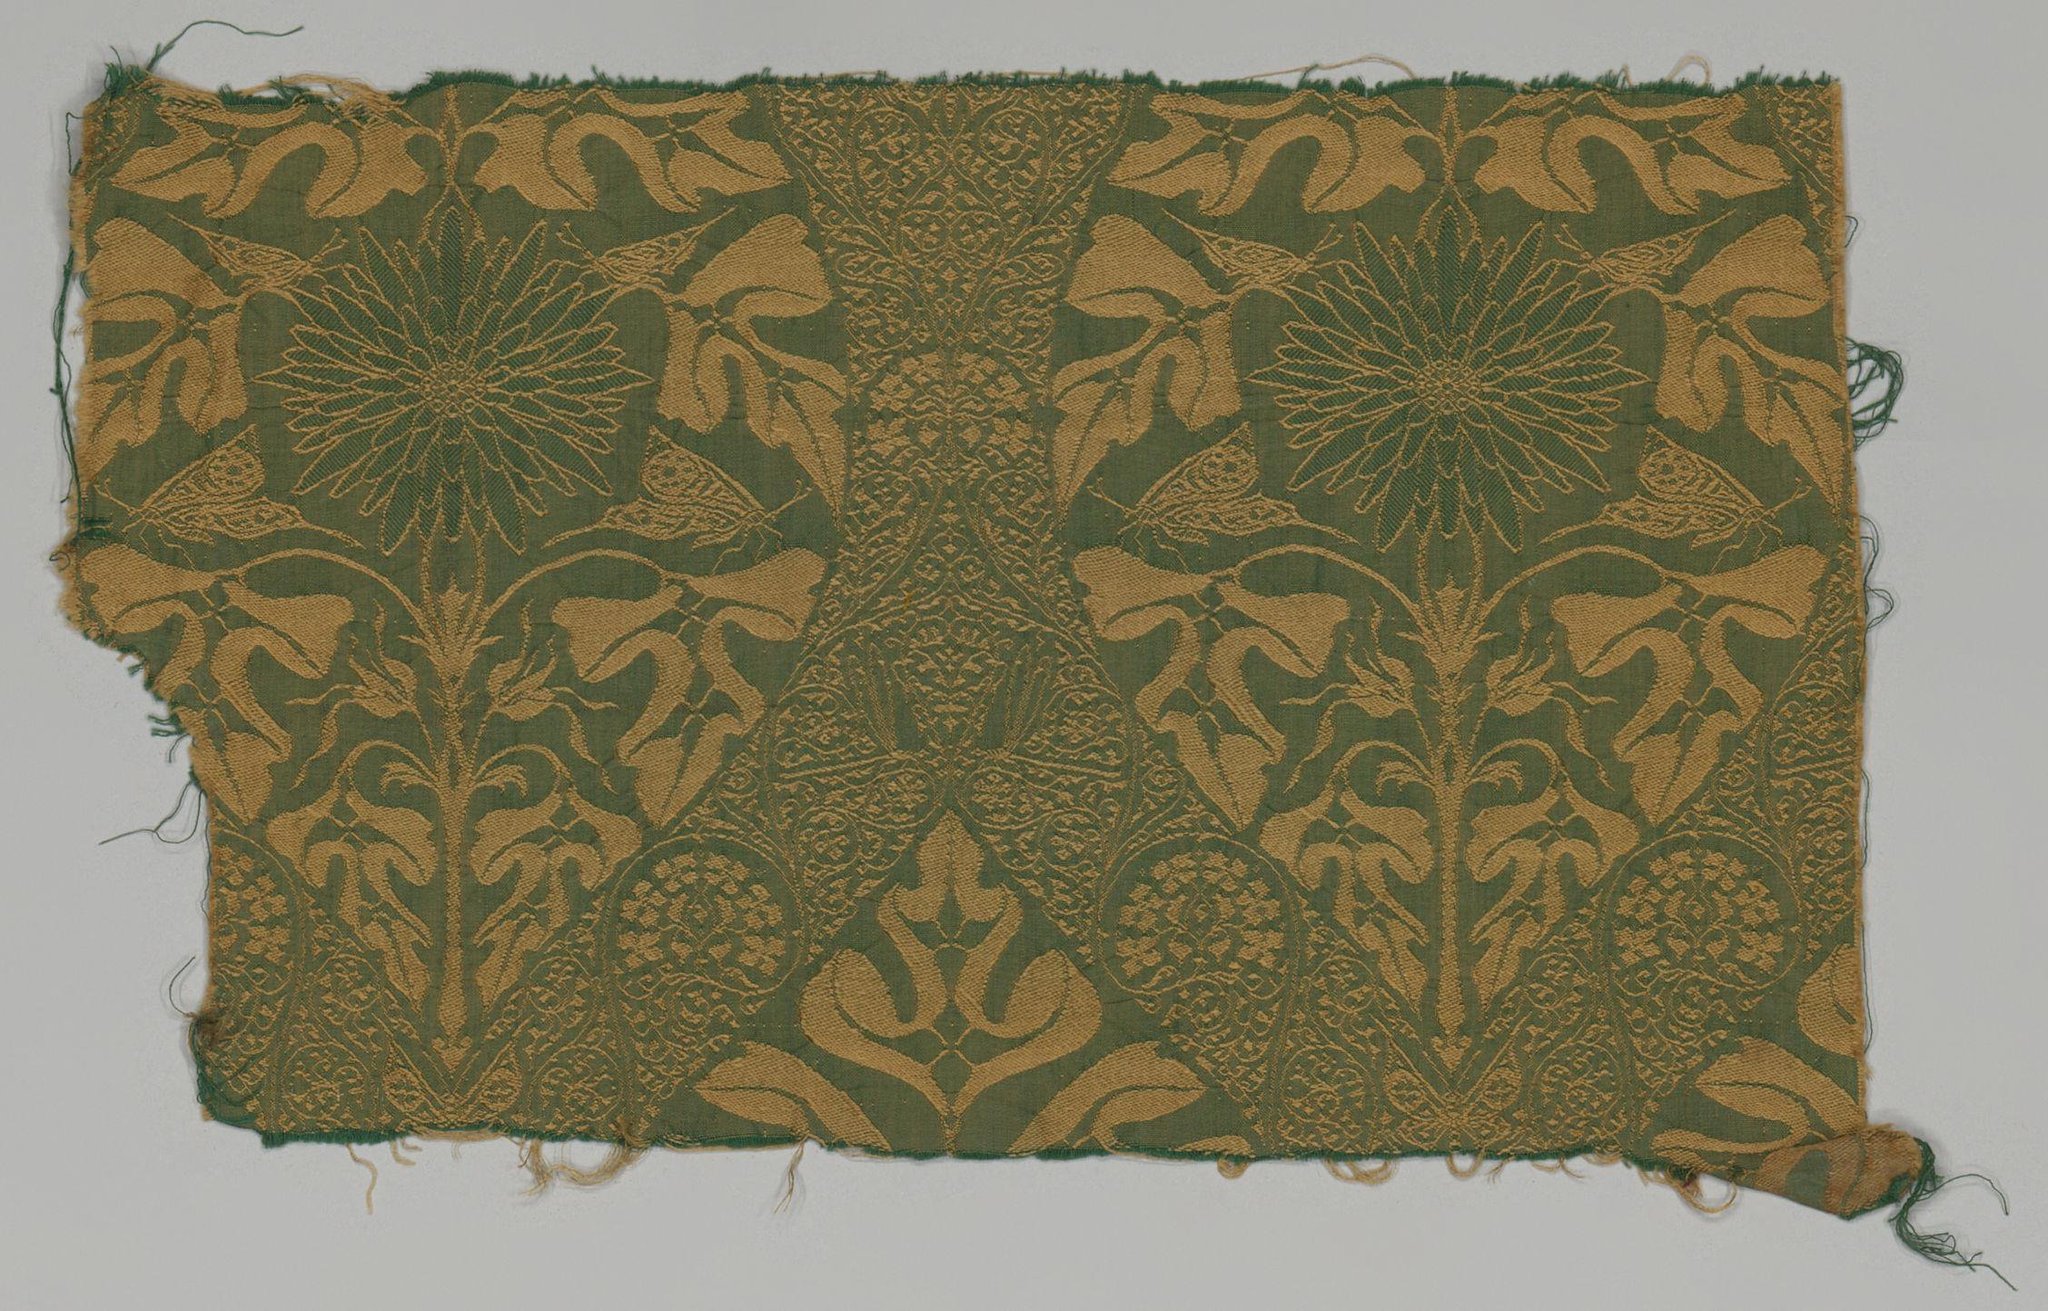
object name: gordijnstof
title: Gordijnstof met een patroon van een aster, bladeren en vlinders in medaillon, goudgeel-groen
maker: theo nieuwenhuis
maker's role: designer, draughtsman, print maker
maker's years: 1866-1951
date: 1909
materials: cotton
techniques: jacquard, weave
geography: netherlands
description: Fragment van jacqurdgeweven katoenen gordijnstof met goudgele inslag op groene ketting. Herhalend dessin van een gestileerde aster, bladeren en vier vlinders in spitsovaalvormige medaillon, omringd door brede banden met klein gestileerde blad-, bloemvormen, vlinders en libelles.